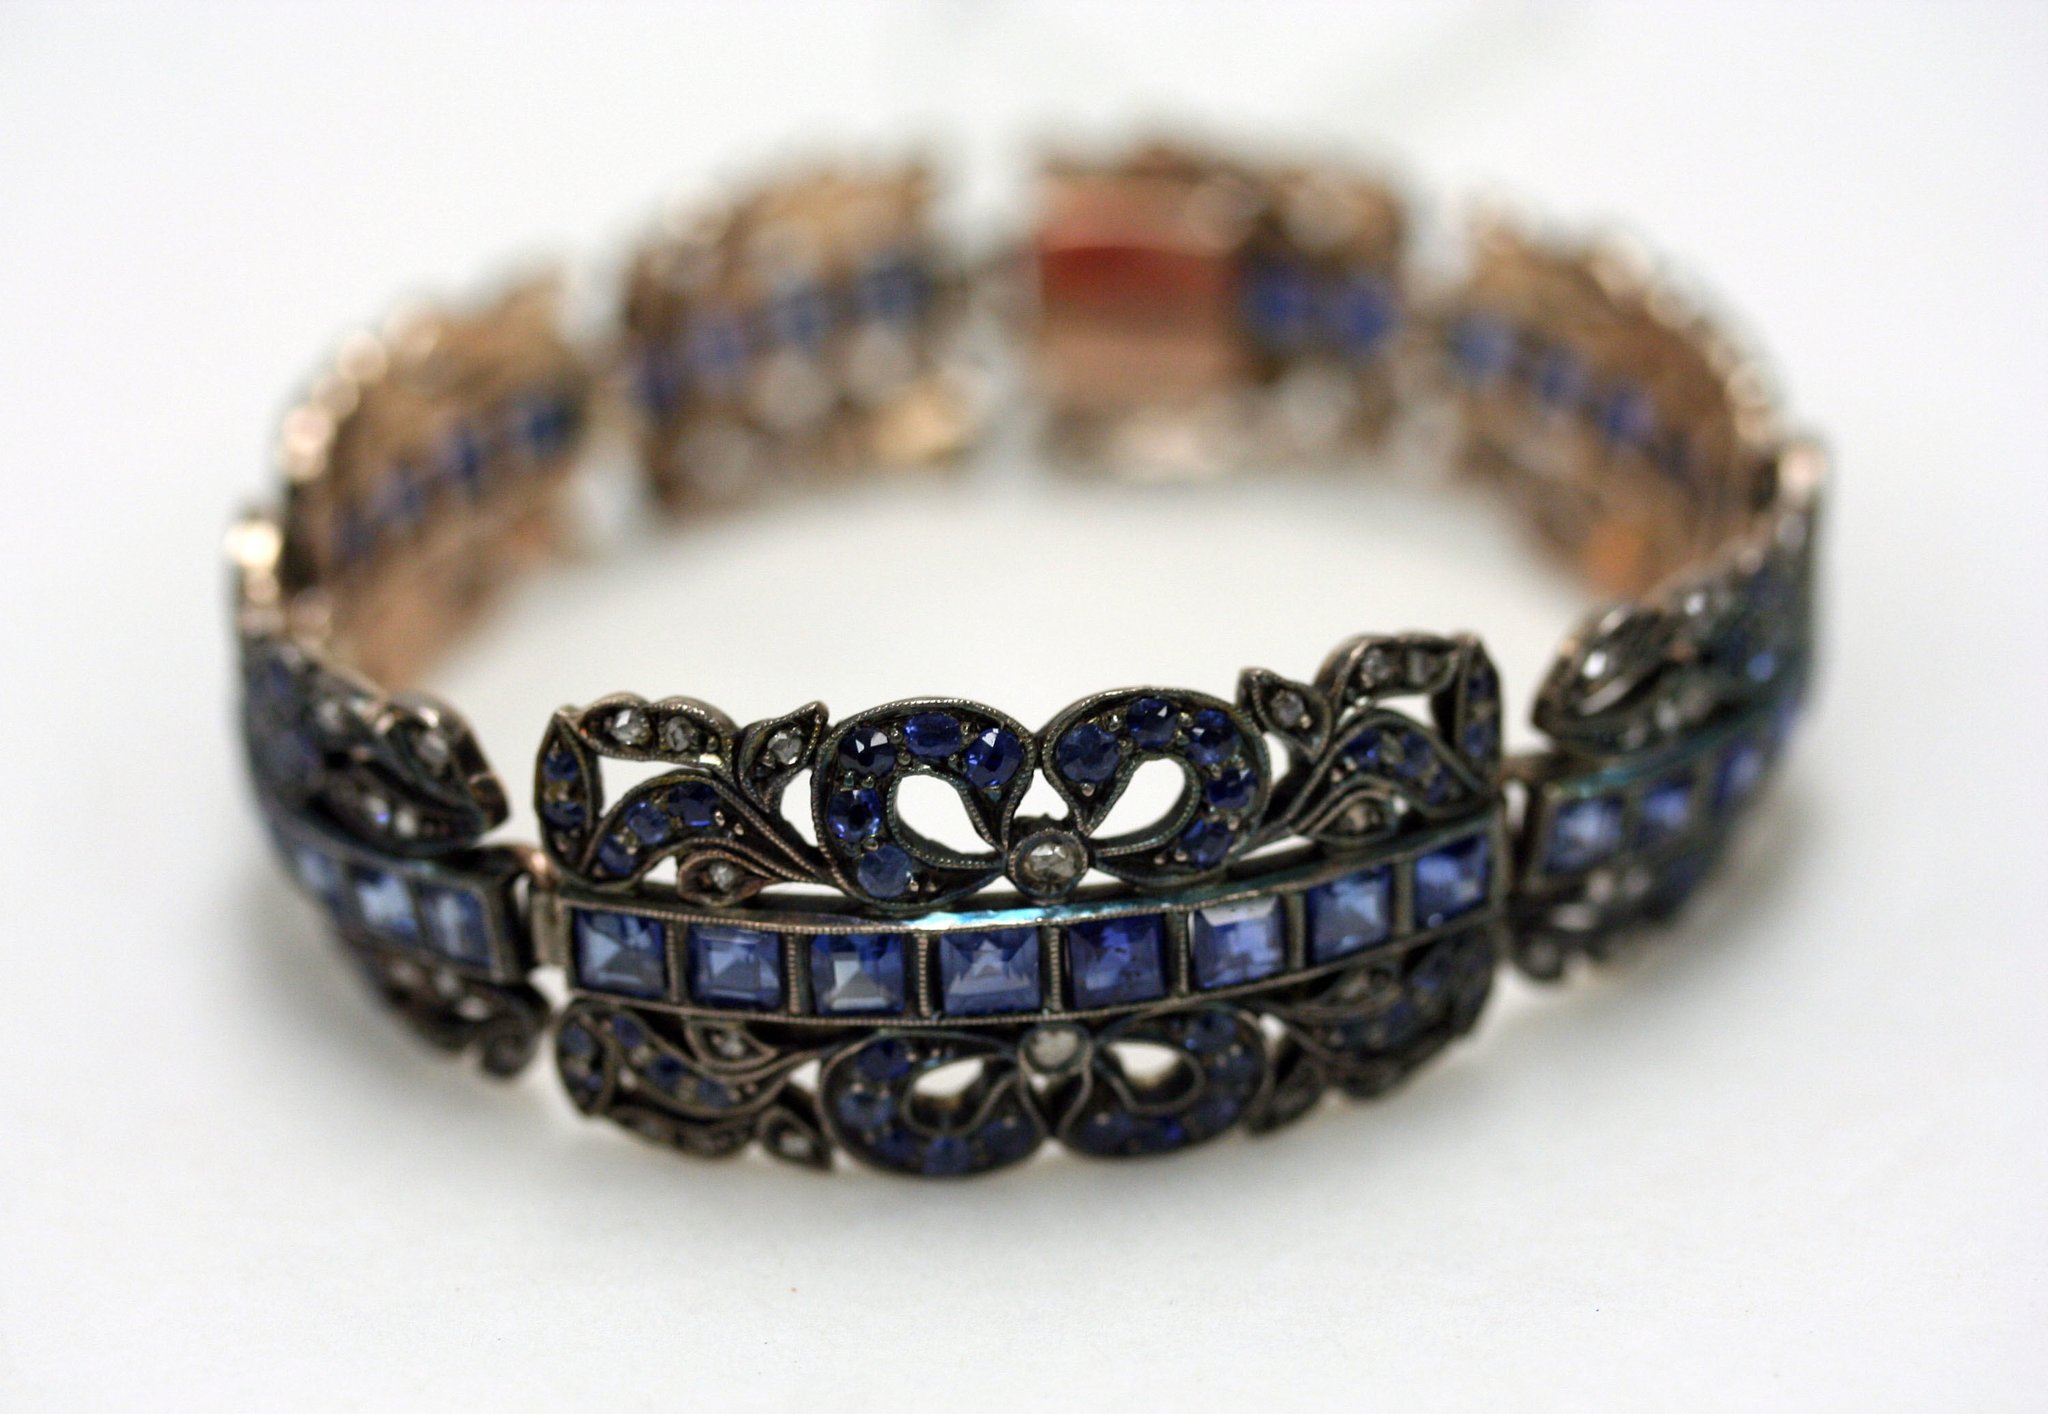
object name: bracelet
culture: austrian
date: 1830-1839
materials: diamond, gold, gemstone